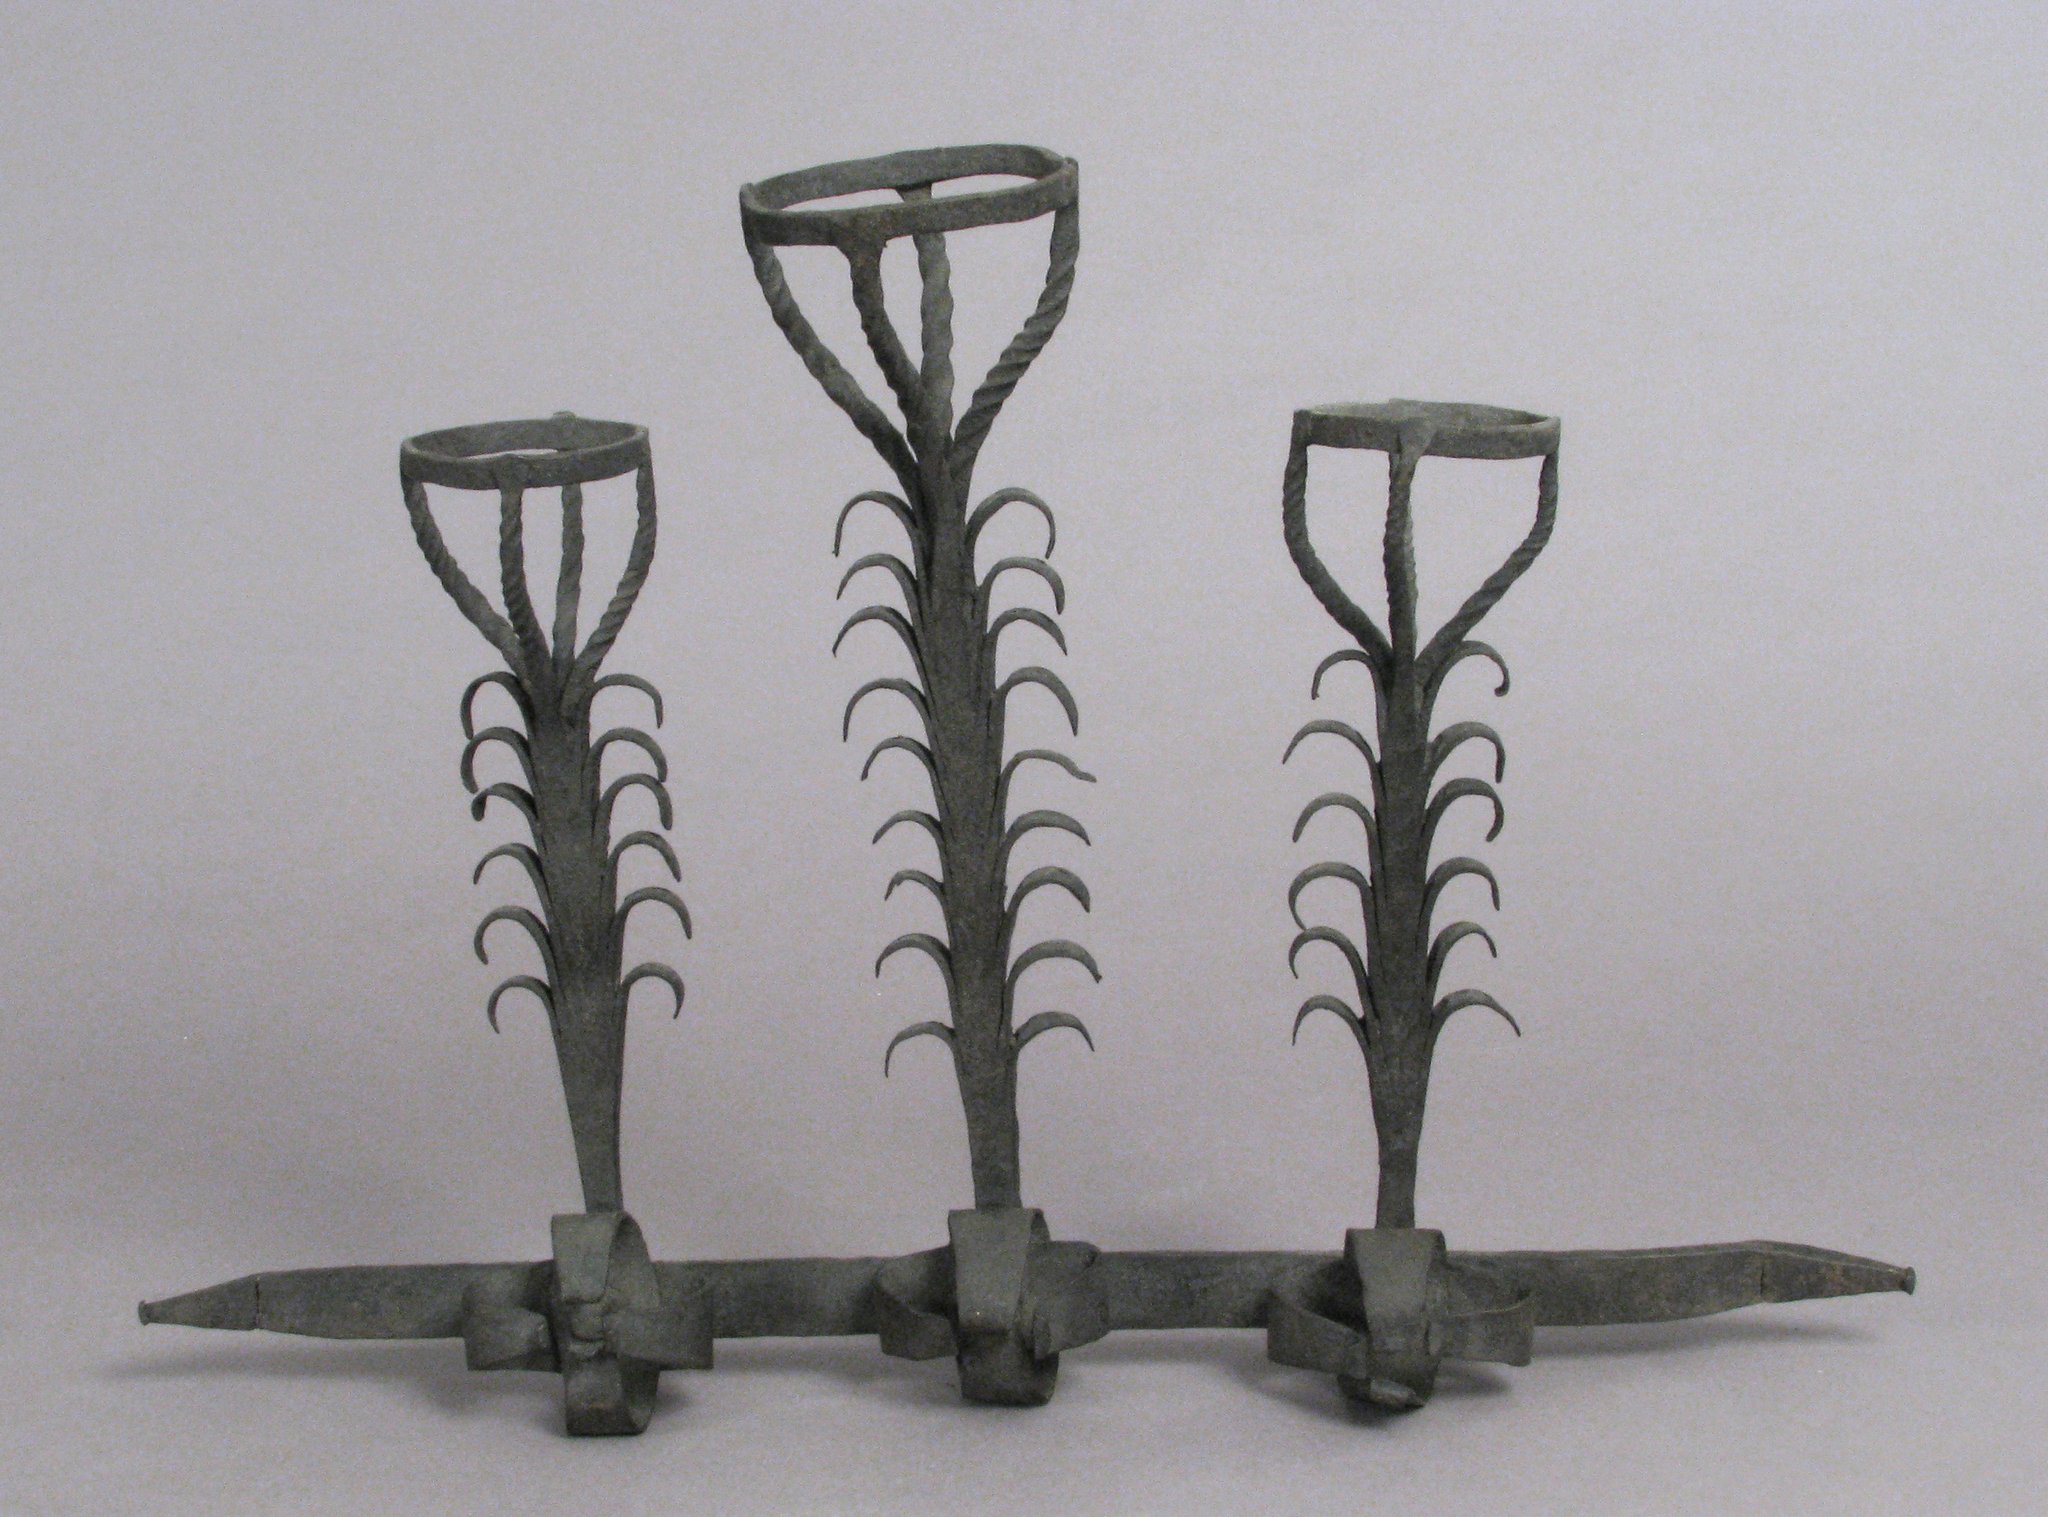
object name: fire screen top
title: Top of a Fire Screen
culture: spanish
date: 1501-1600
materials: iron